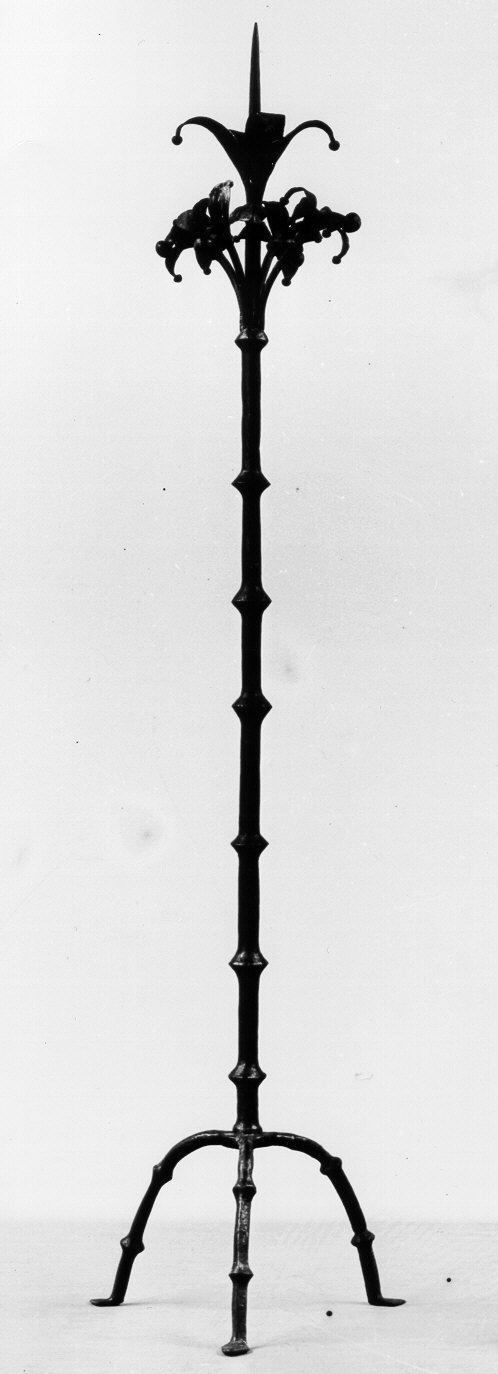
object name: candelabrum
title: Candelabra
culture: spanish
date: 1301-1400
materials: iron